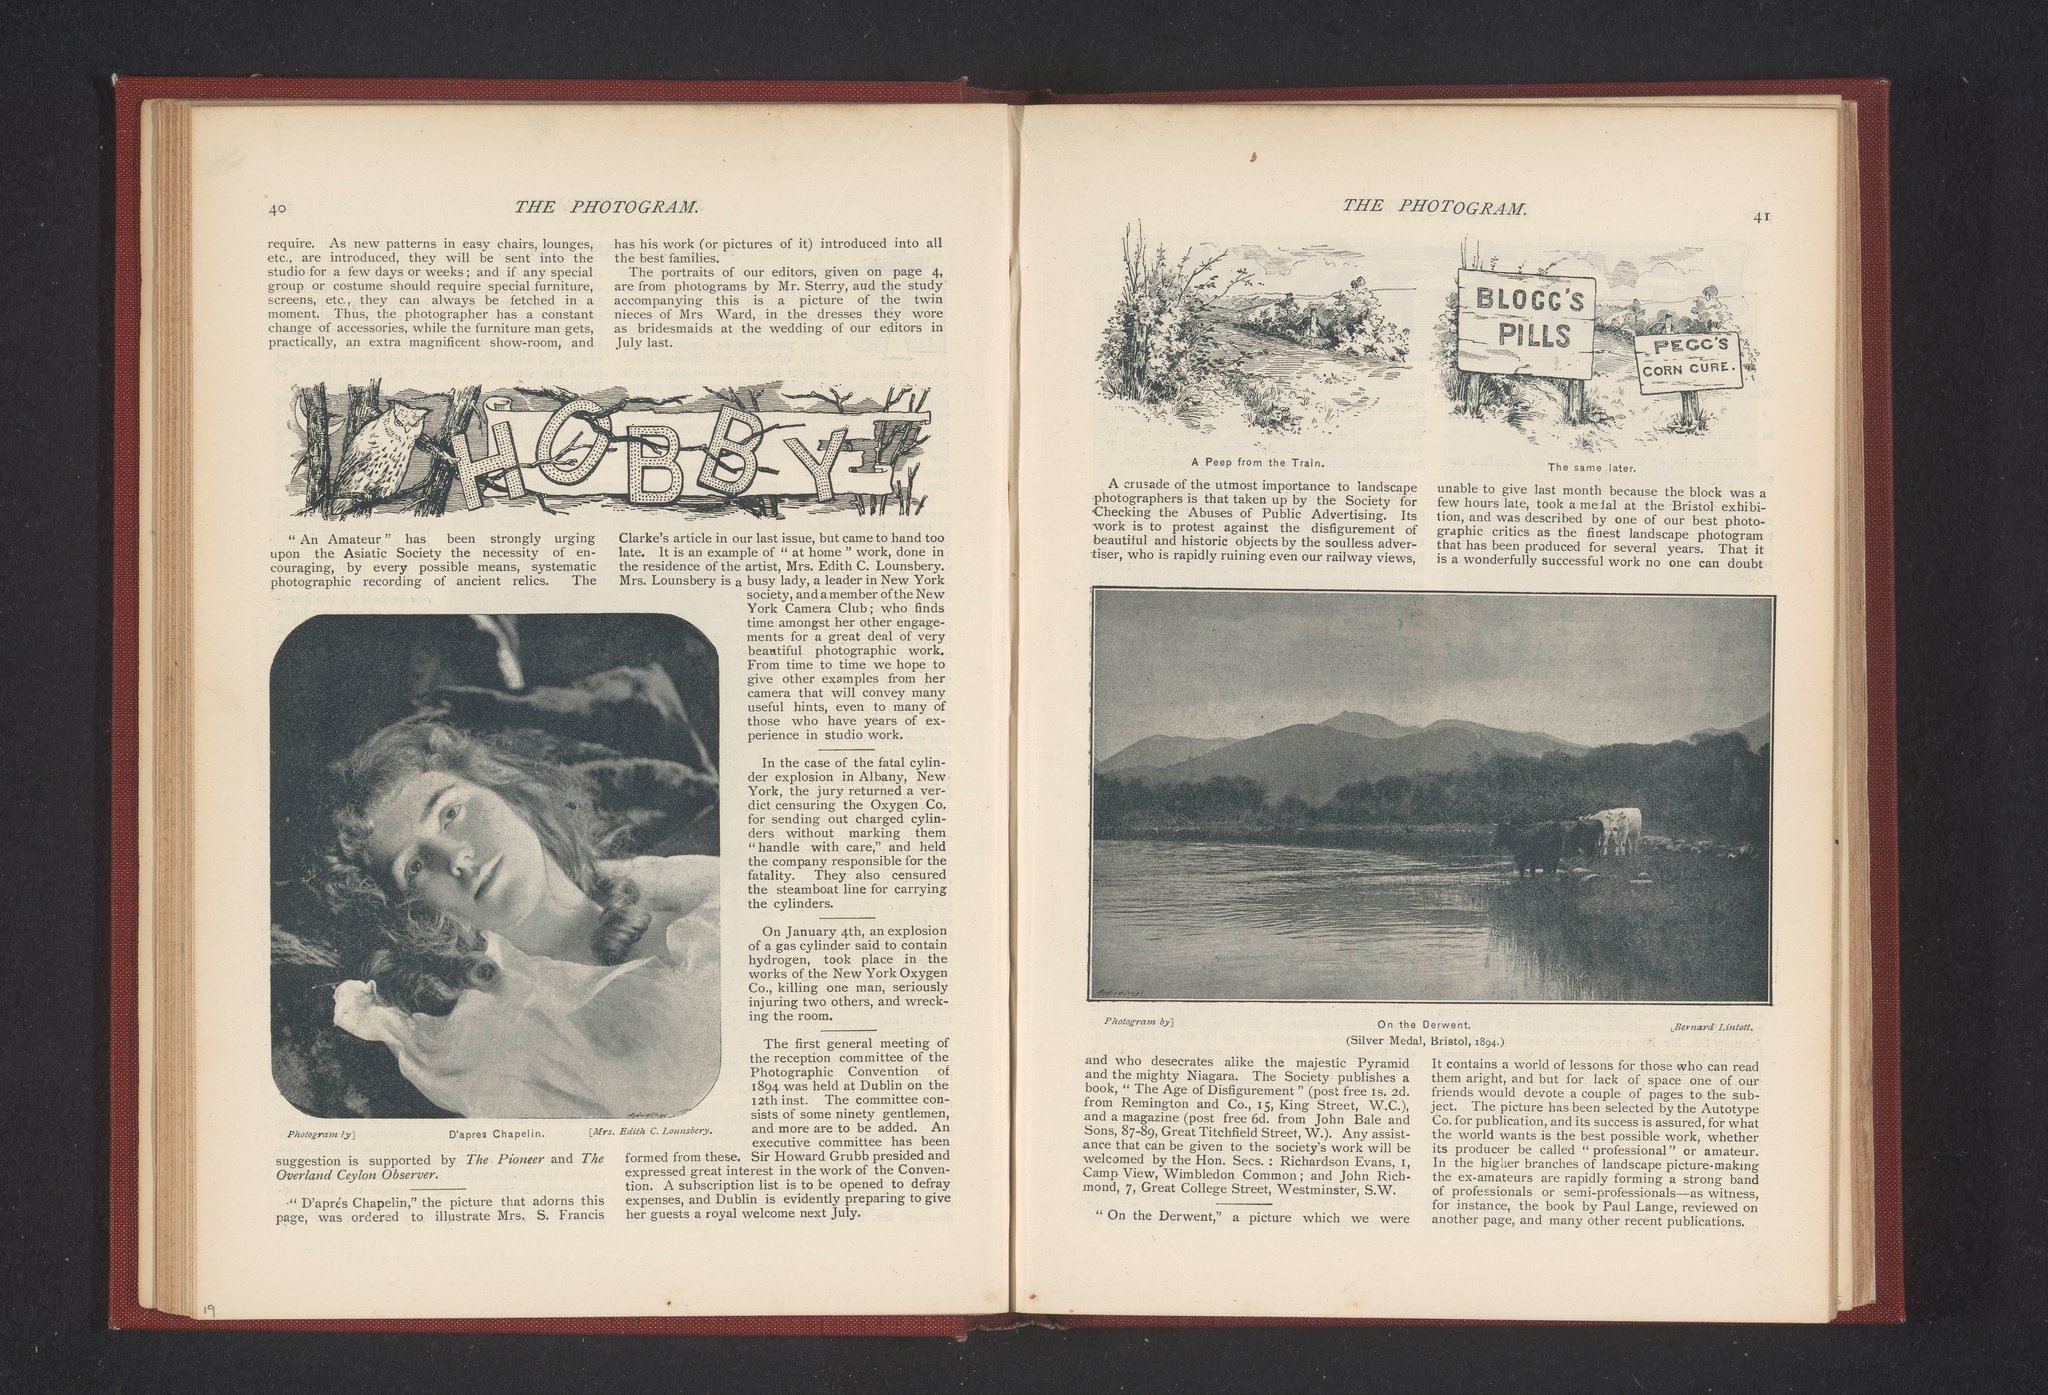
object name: photomechanical print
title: Portret van een onbekende vrouw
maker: edith c. lounsbery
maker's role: fotograaf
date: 1889-1894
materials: paper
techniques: autotype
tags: historical persons - bb - woman